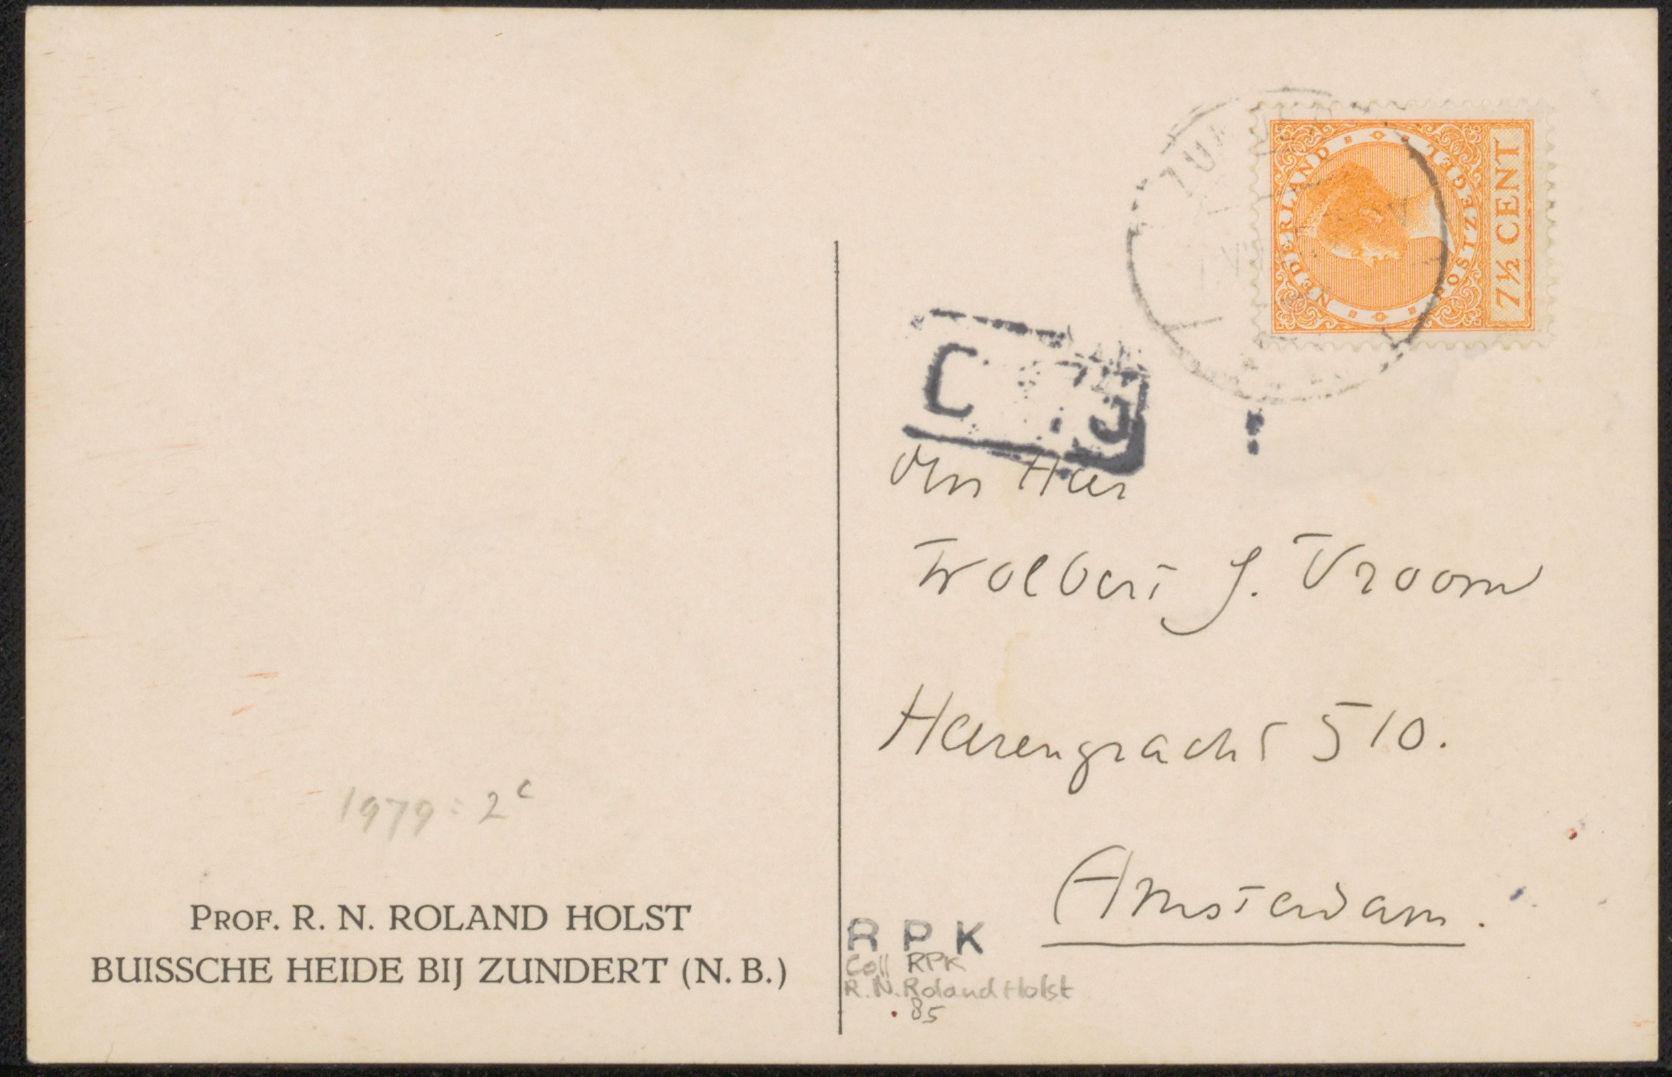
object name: postcard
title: Briefkaart aan Wolbert J. Vroom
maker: richard nicolaüs roland holst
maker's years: 1868-1938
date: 1925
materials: cardboard, ink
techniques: pen, writing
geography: zundert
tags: drawing, the graphic arts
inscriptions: collector's mark: ‘RPK’